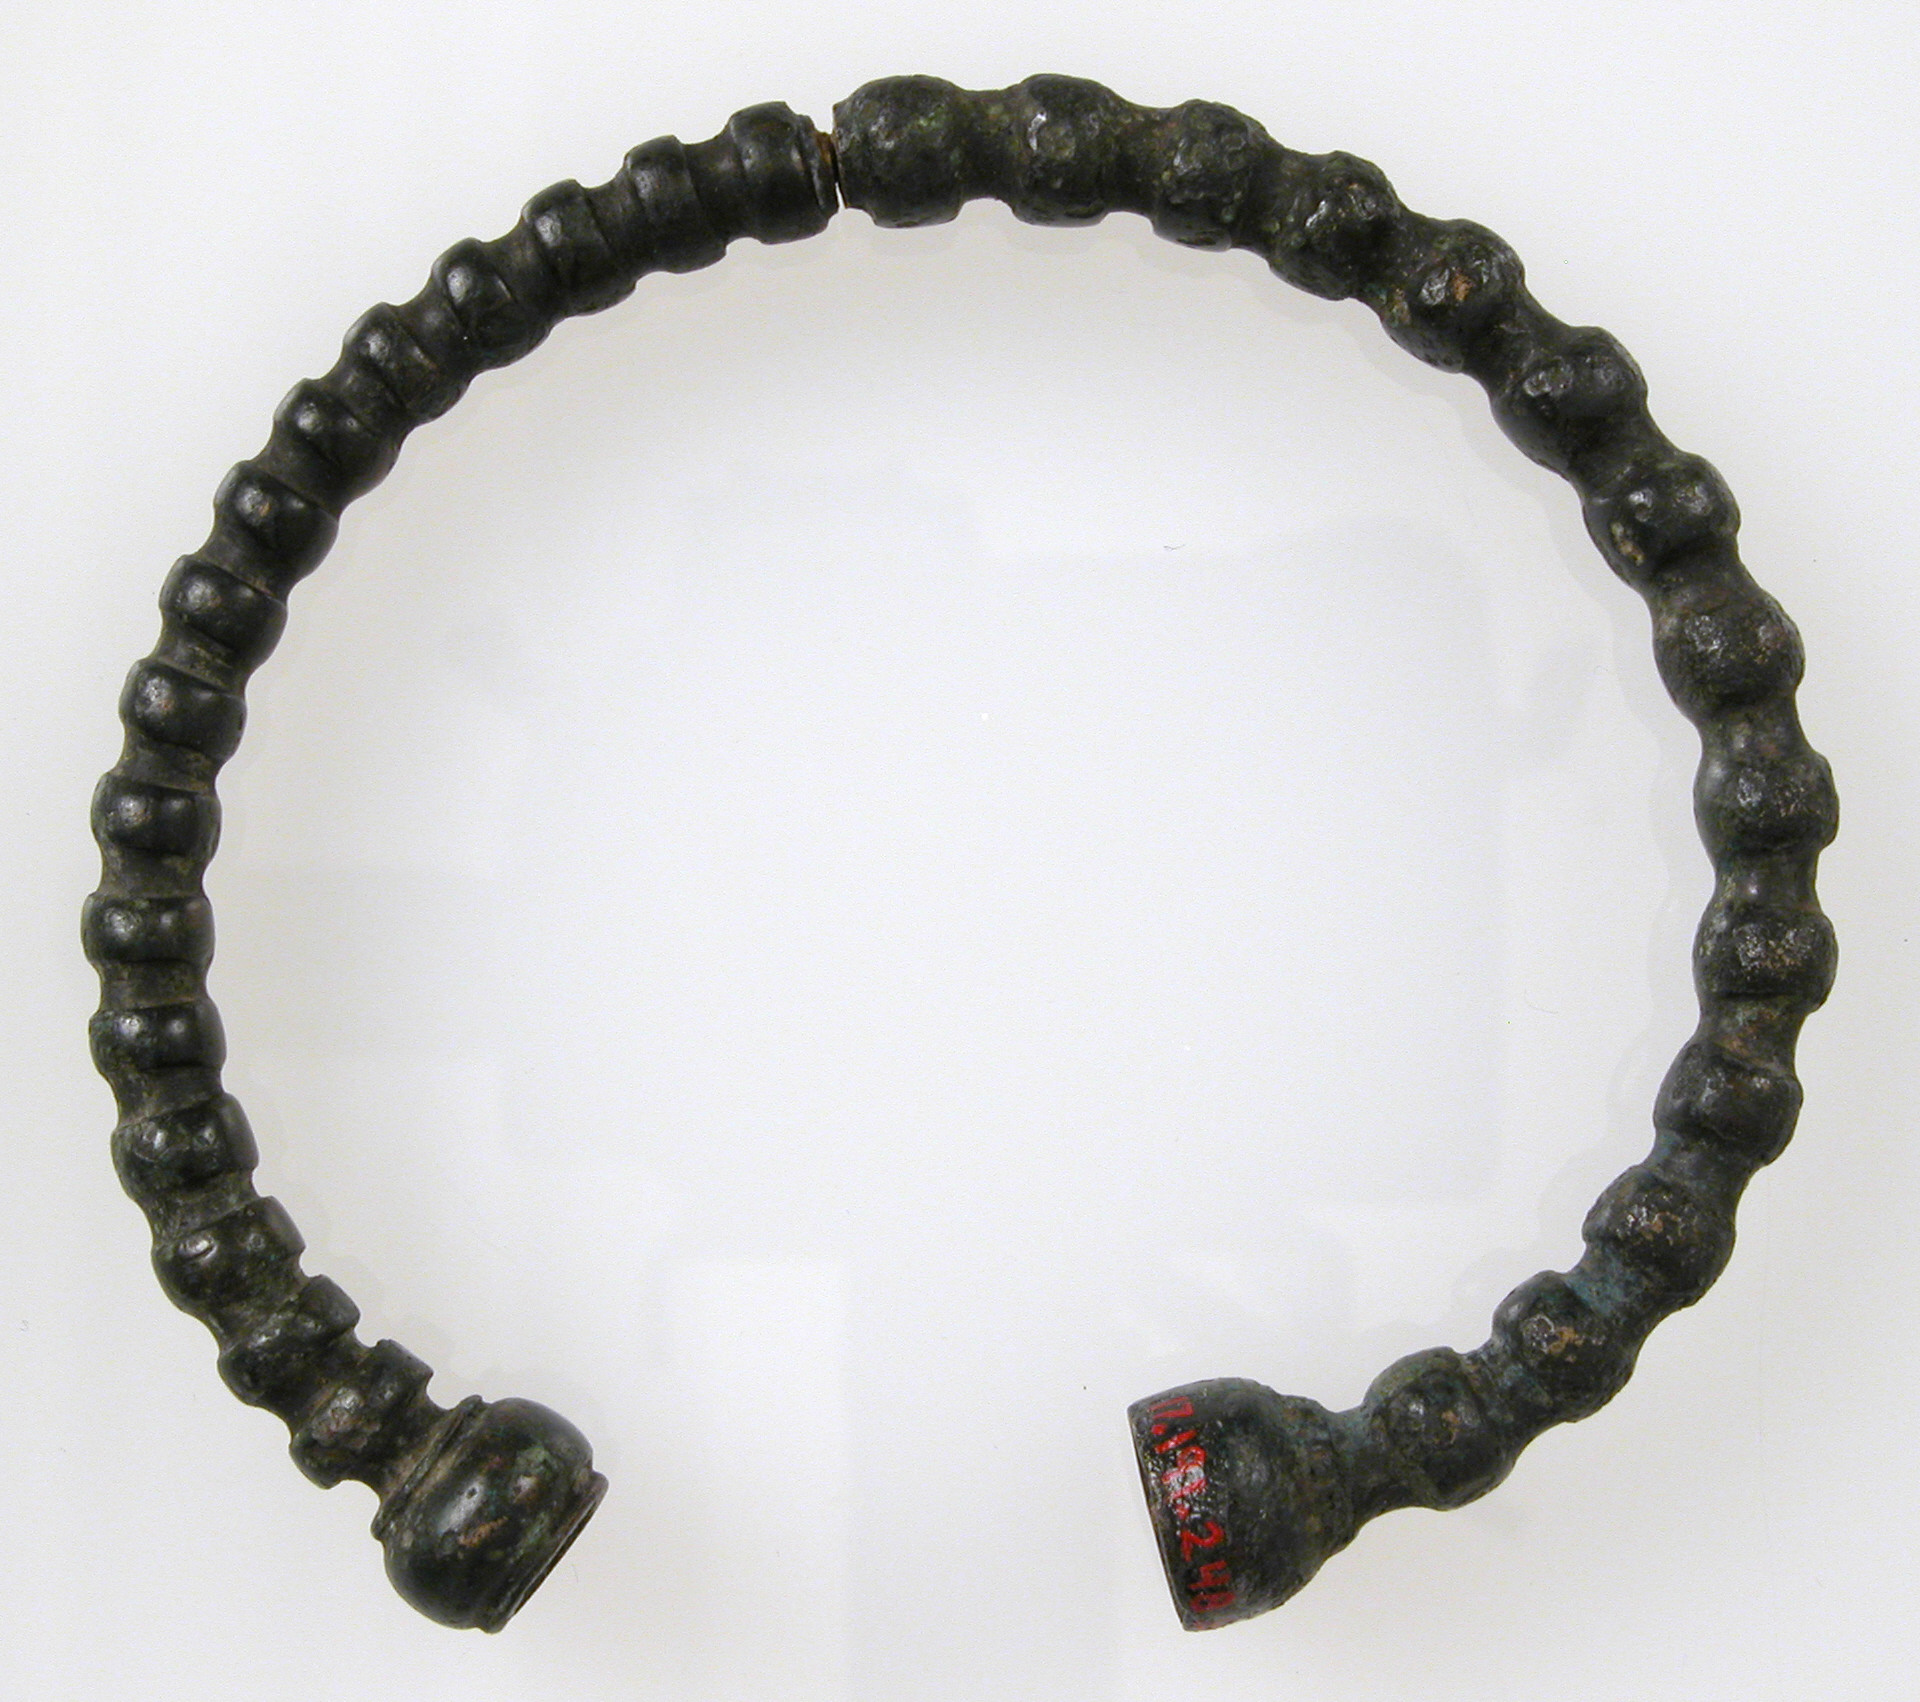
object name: bracelet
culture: celtic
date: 400-301 BCE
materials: copper alloy